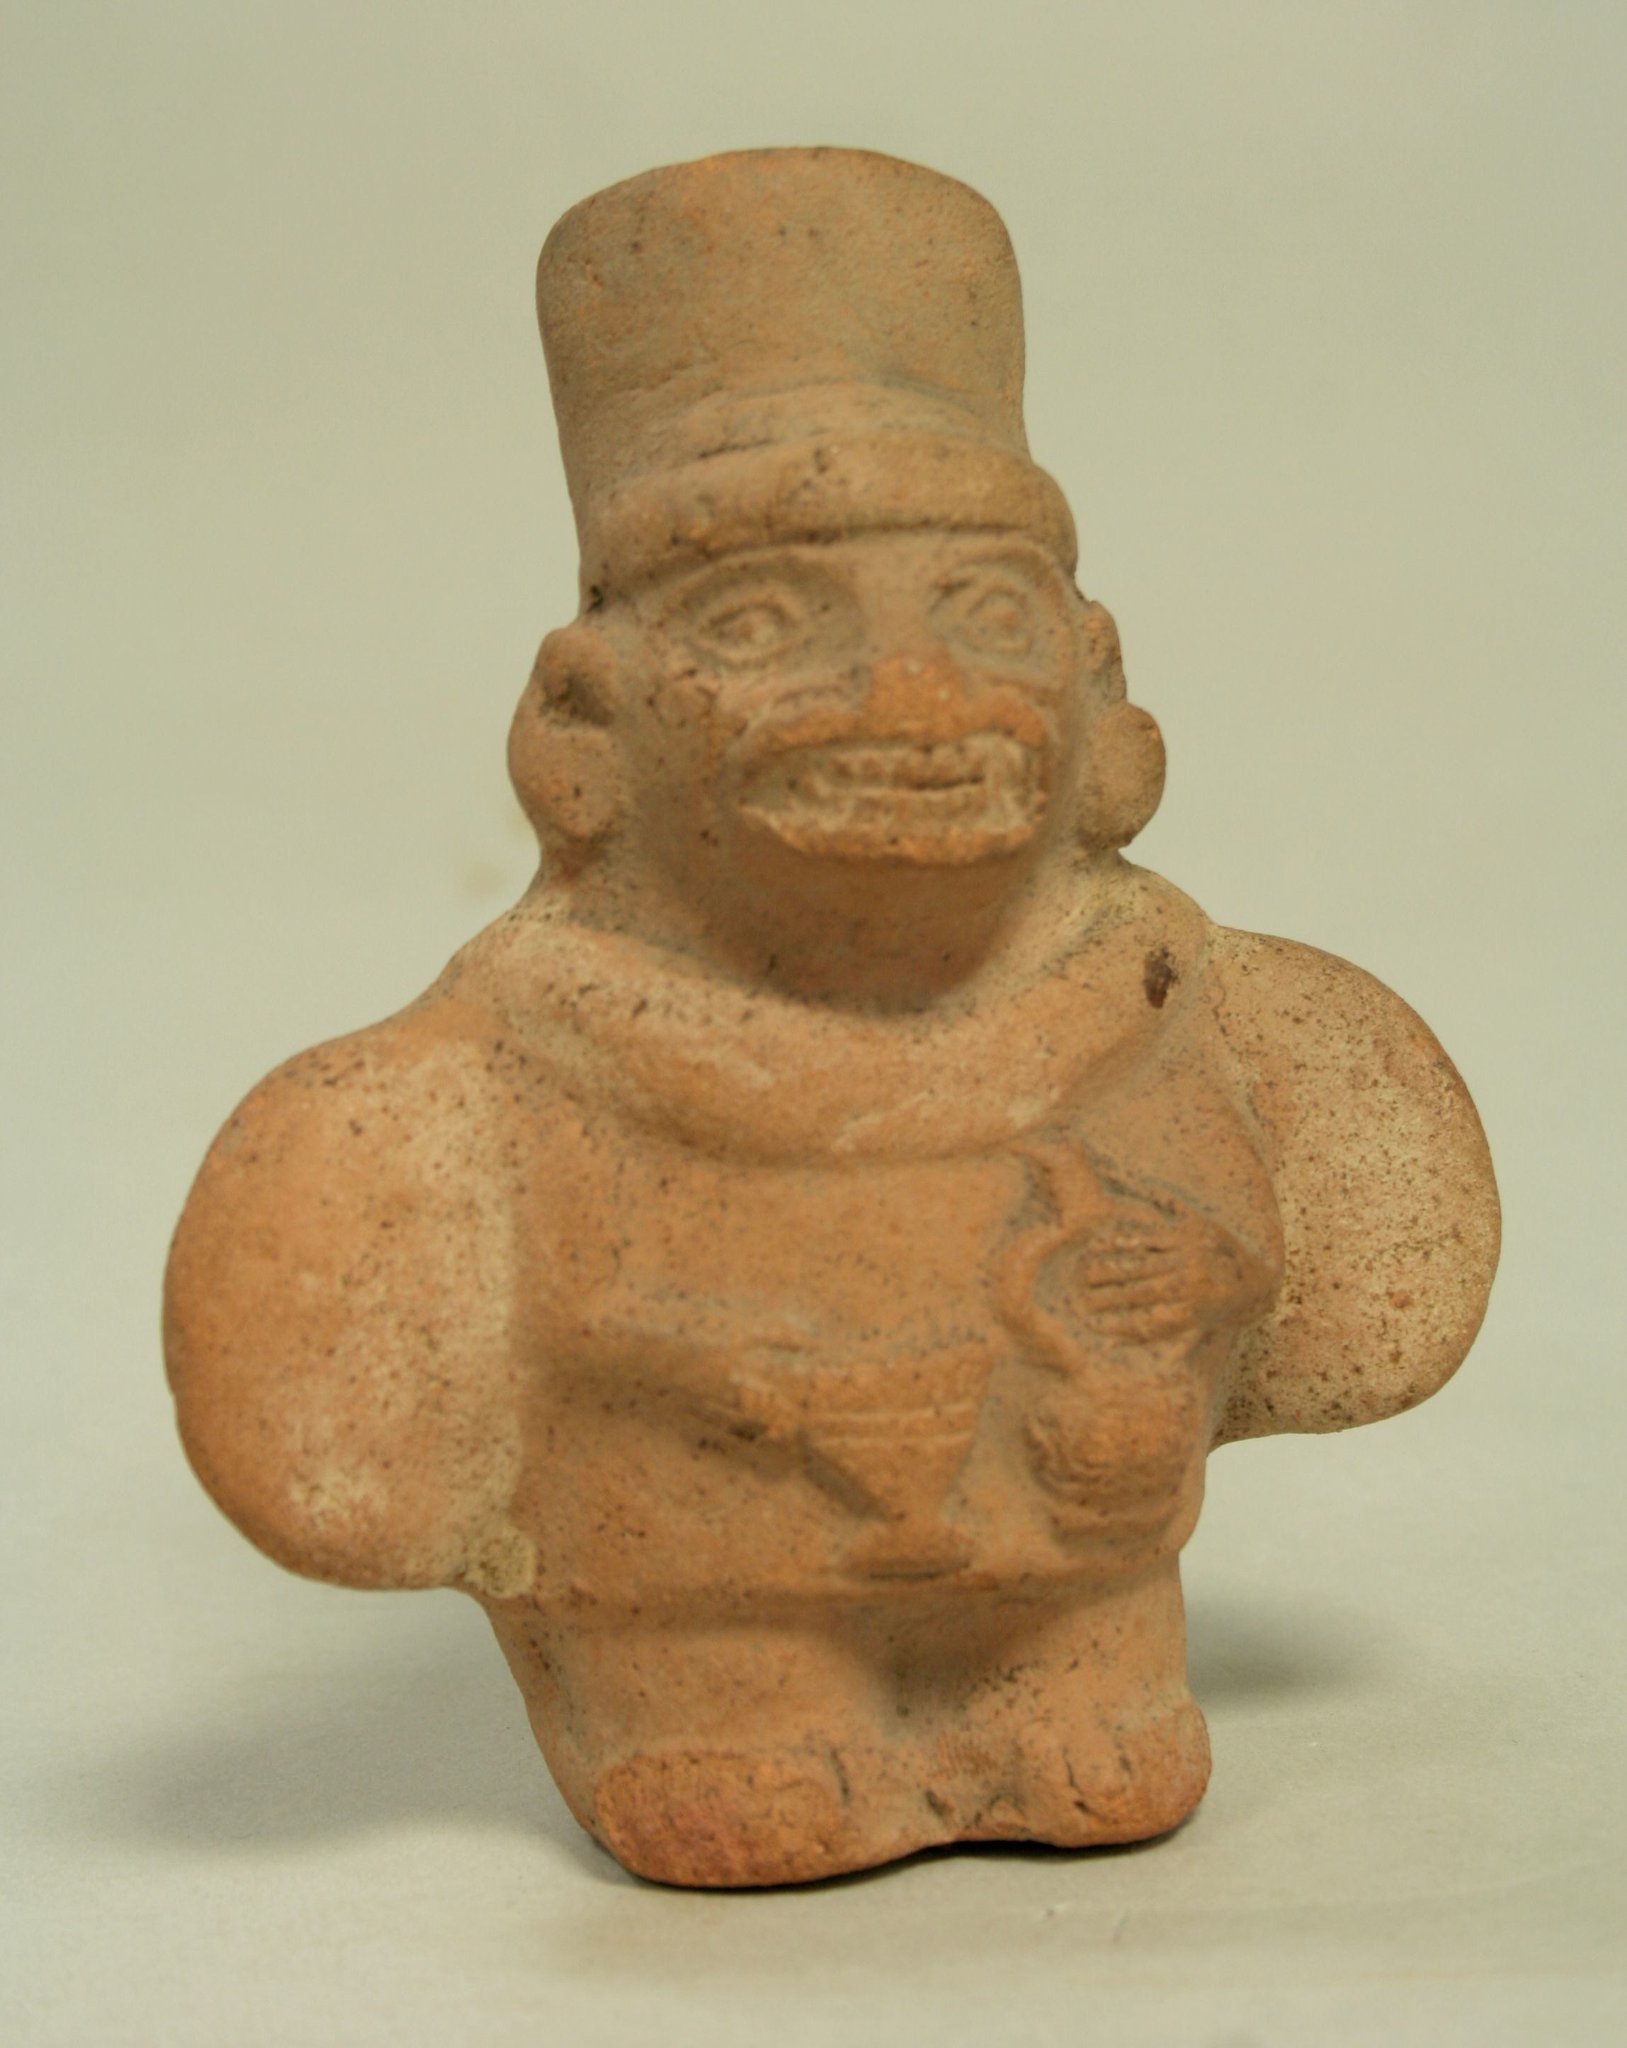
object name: bottle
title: Single Spout (Ai-Apec) Figure Bottle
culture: moche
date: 301-700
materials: ceramic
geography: peru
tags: men